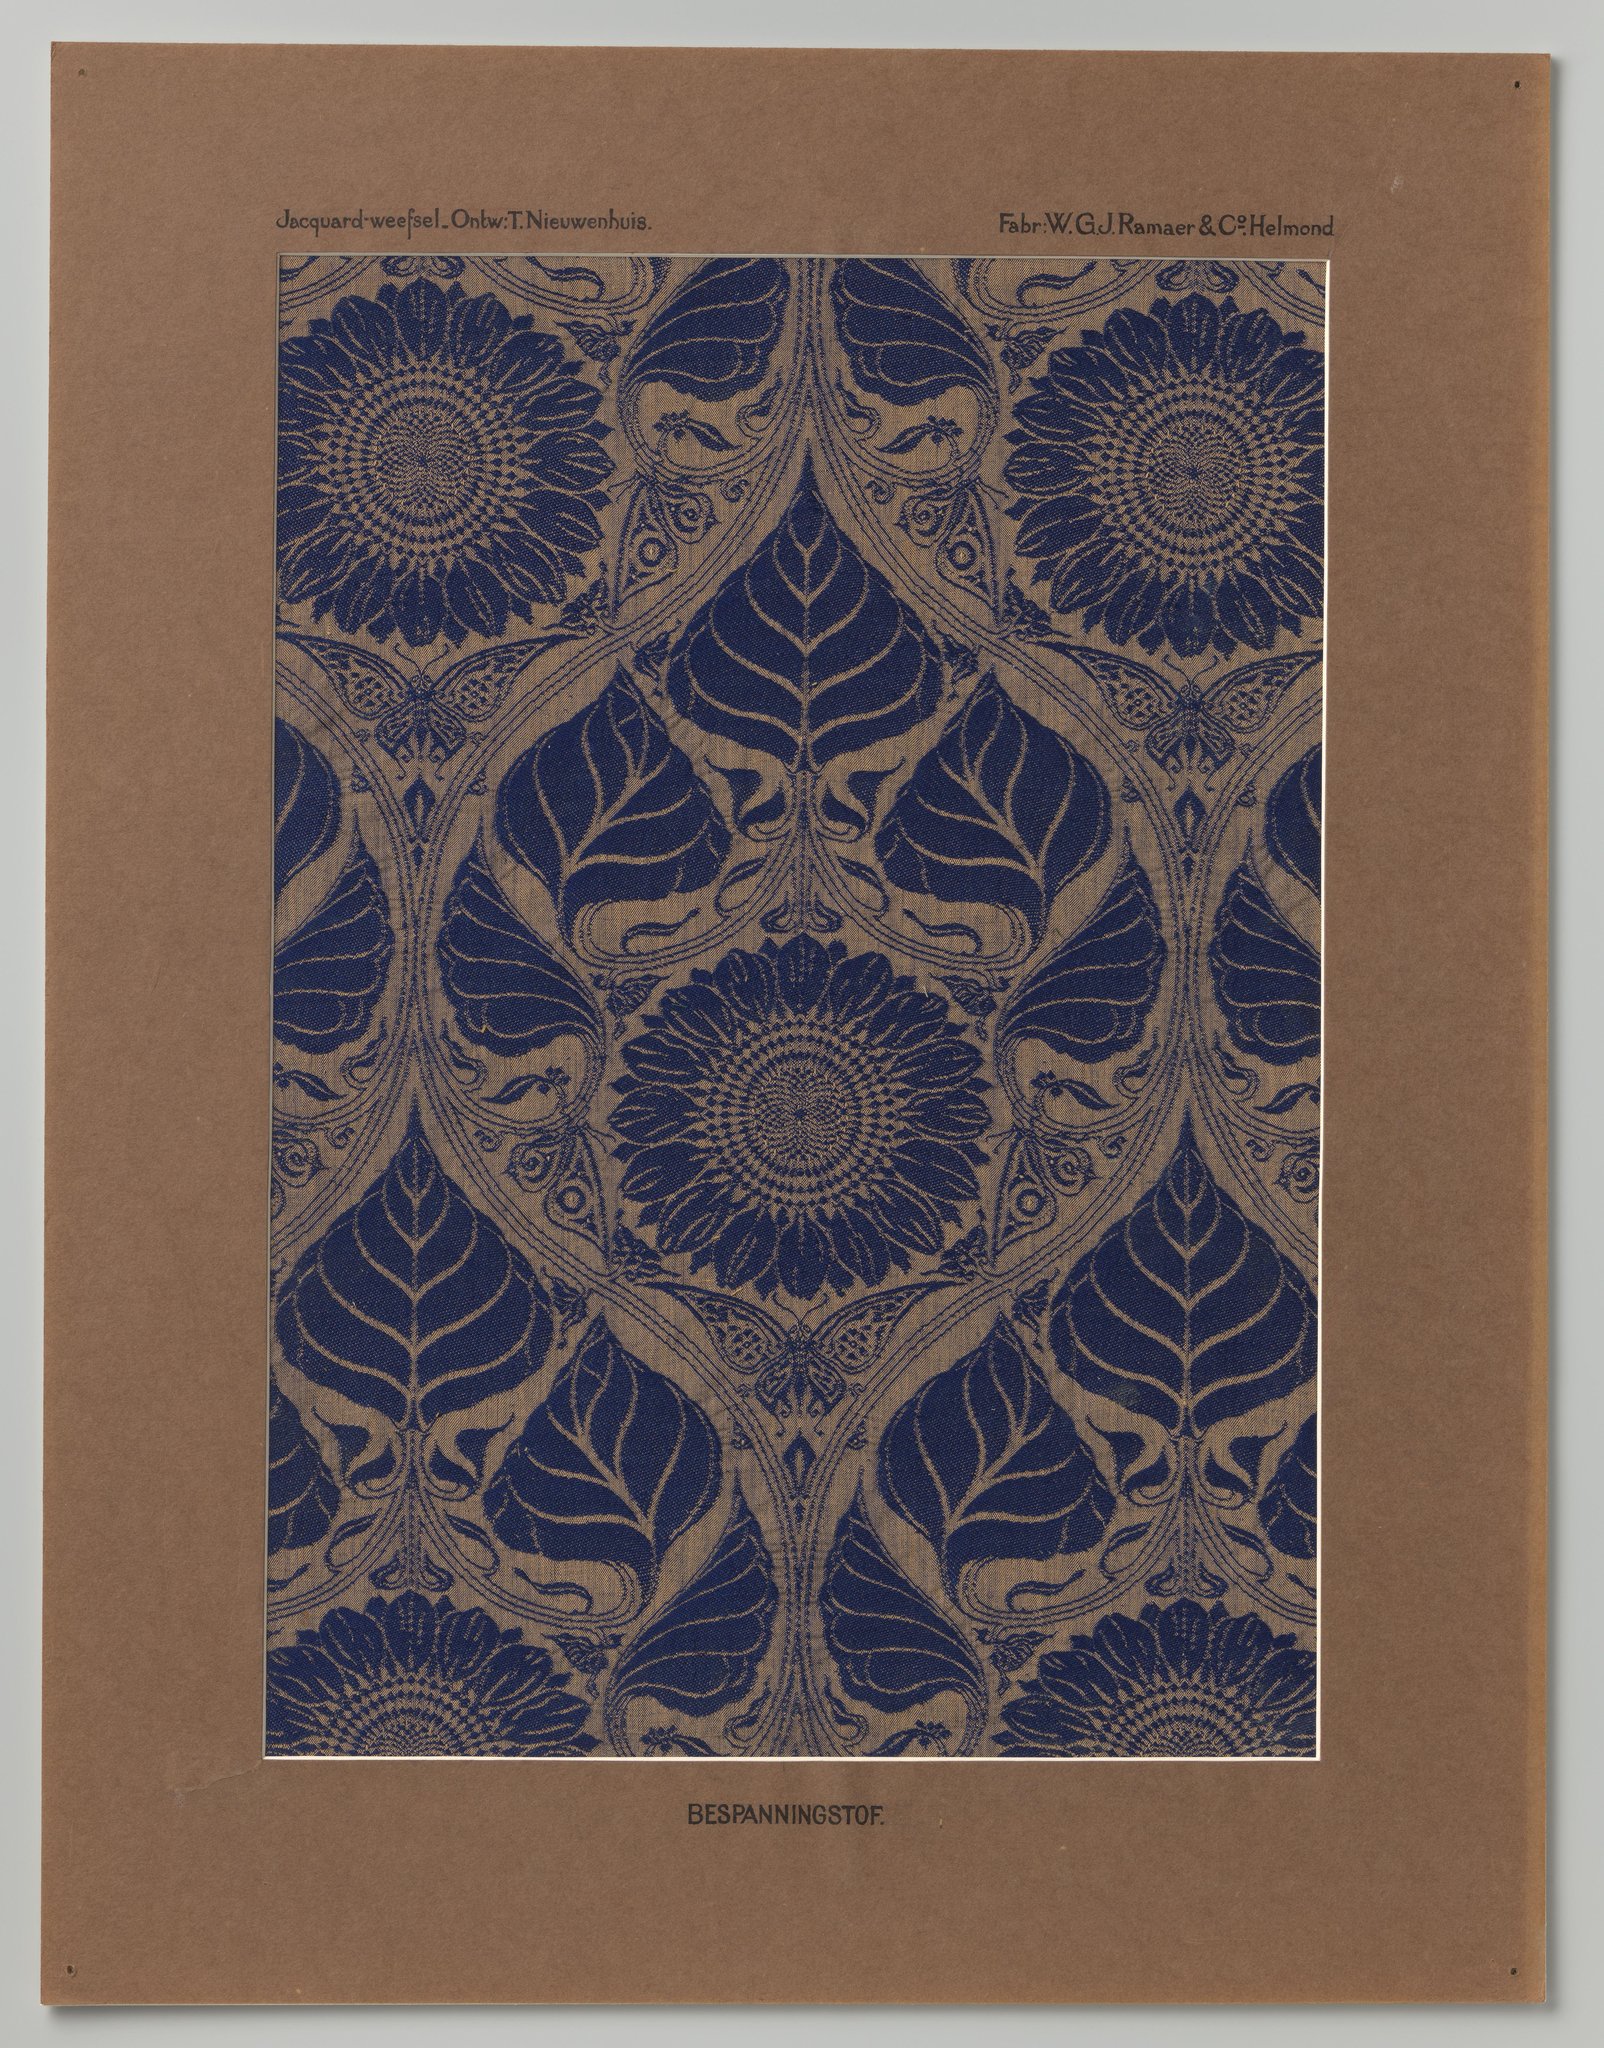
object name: upholstery fabric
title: Staal bespanningsstof naar ontwerp van Theo Nieuwenhuis in passe-partout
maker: theo nieuwenhuis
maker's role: designer, draughtsman, print maker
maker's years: 1866-1951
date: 1910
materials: cardboard, cotton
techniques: jacquard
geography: helmond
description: Staal van bespanningsstof naar ontwerp van Theo Nieuwenhuis, in origineel passe-partout. Het patroon bestaat uit zonnebloemen, bladeren en vlinders in spitsovaal. Blauwe inslag op beige ketting.